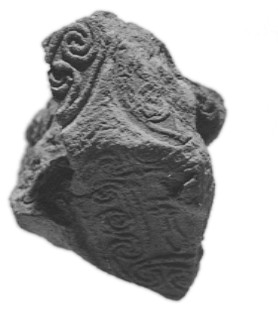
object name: sealing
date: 2030-1640 BCE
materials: clay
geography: egypt